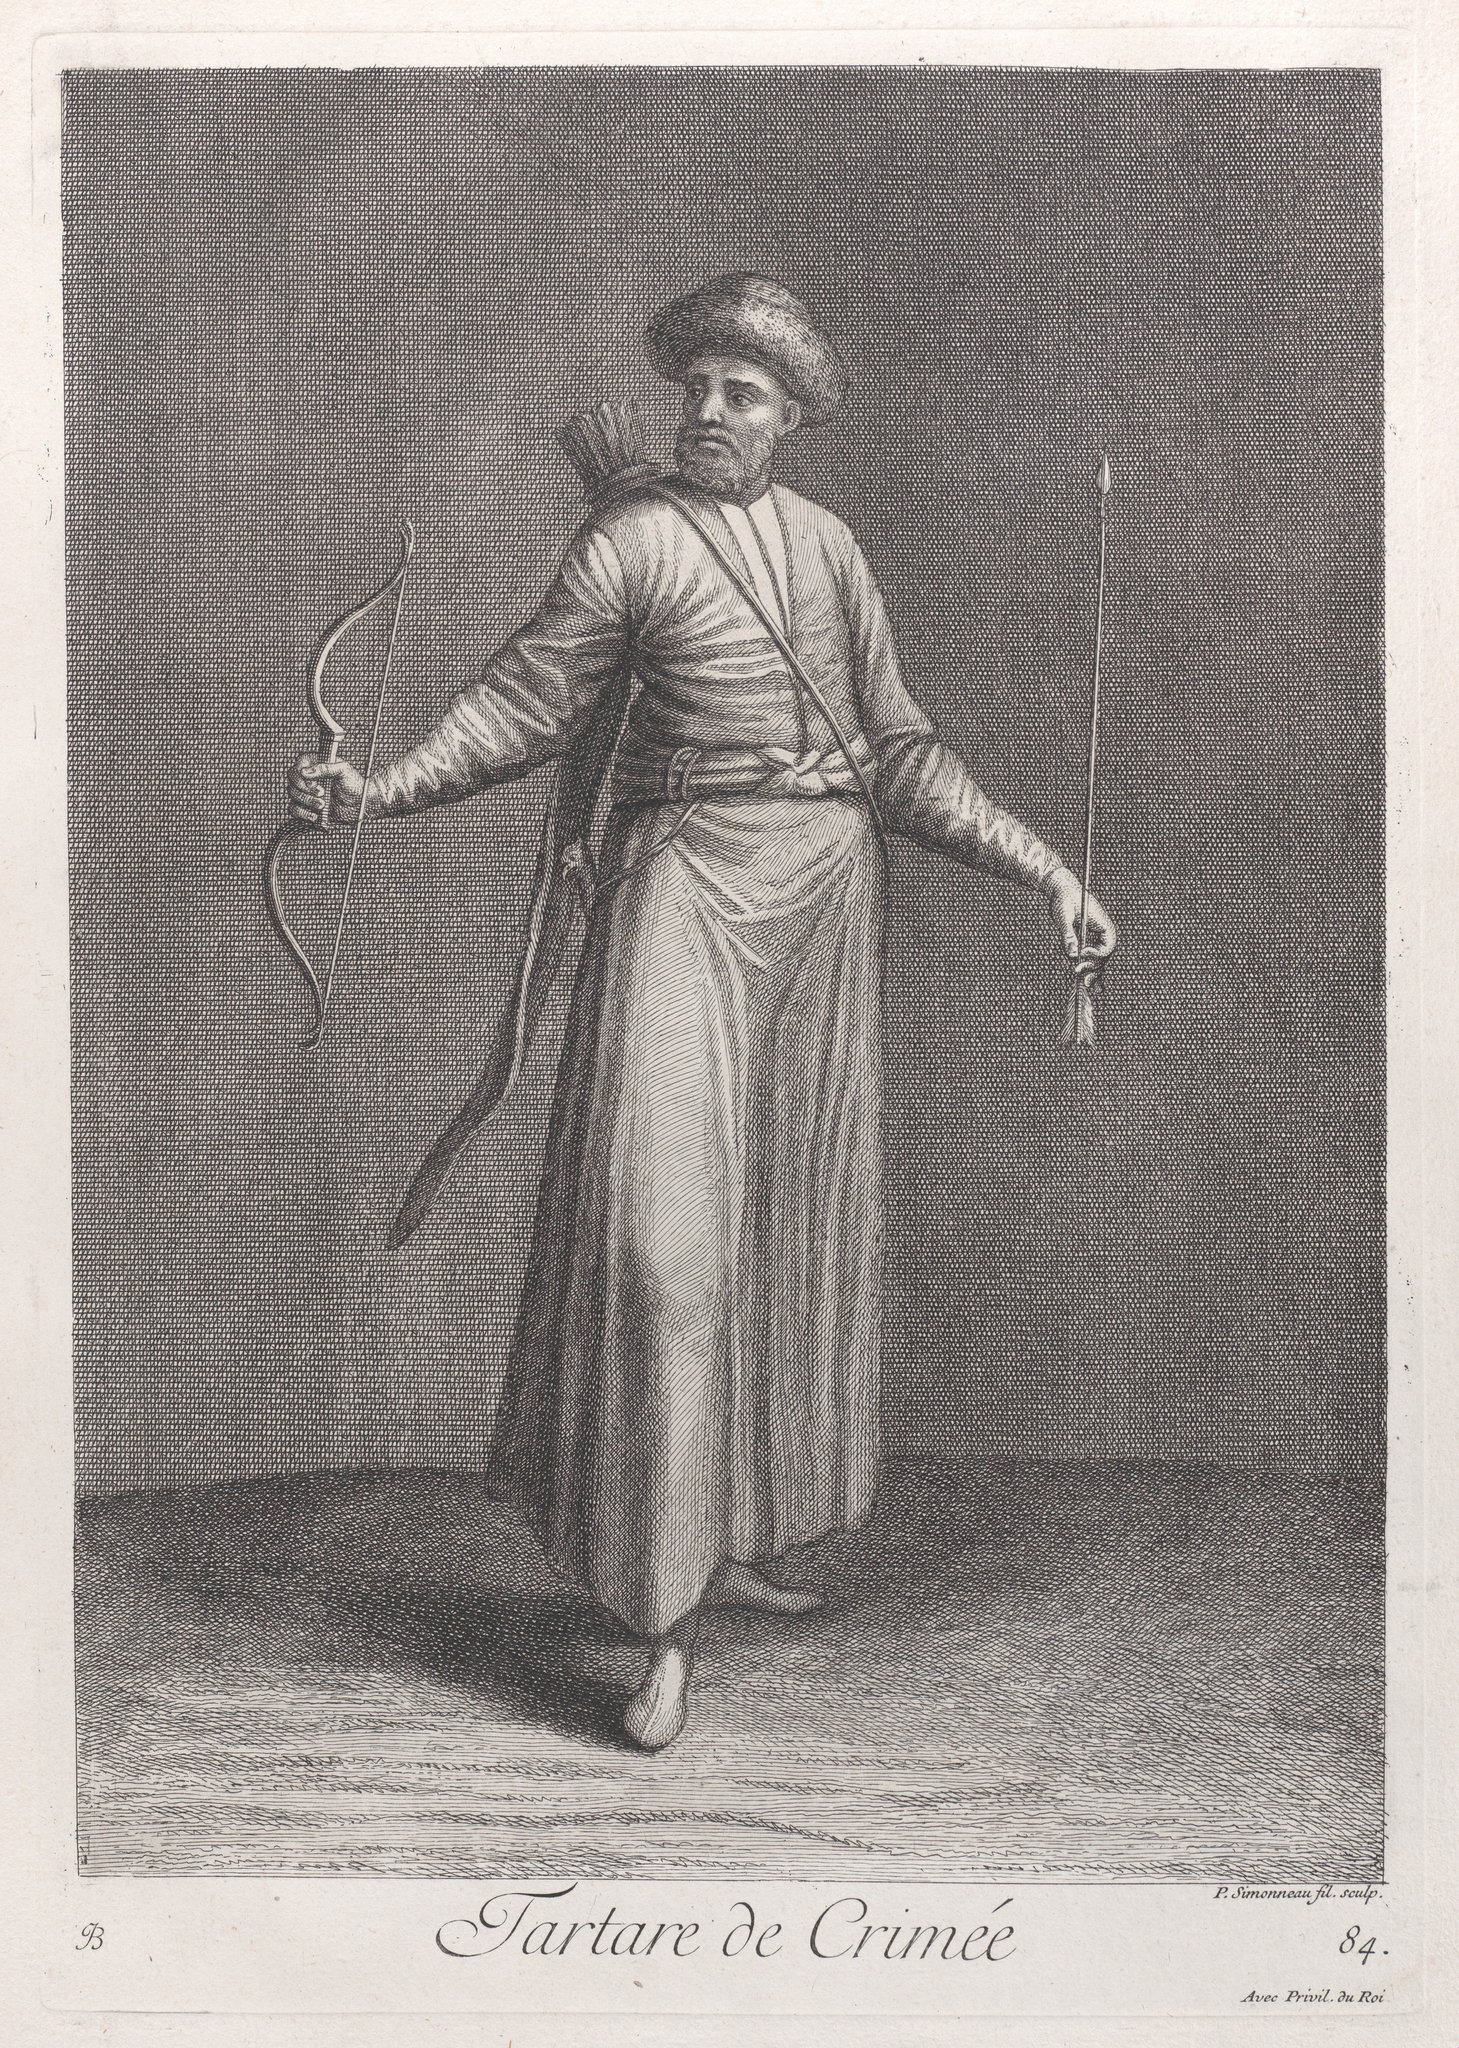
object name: print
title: Tartare de Crimée, plate 84 from "Recueil de cent estampes représentent differentes nations du Levant"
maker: jean baptiste vanmour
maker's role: artist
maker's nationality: french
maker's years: 1671-1737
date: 1714-1715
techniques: engraving, etching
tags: bow and arrow,men